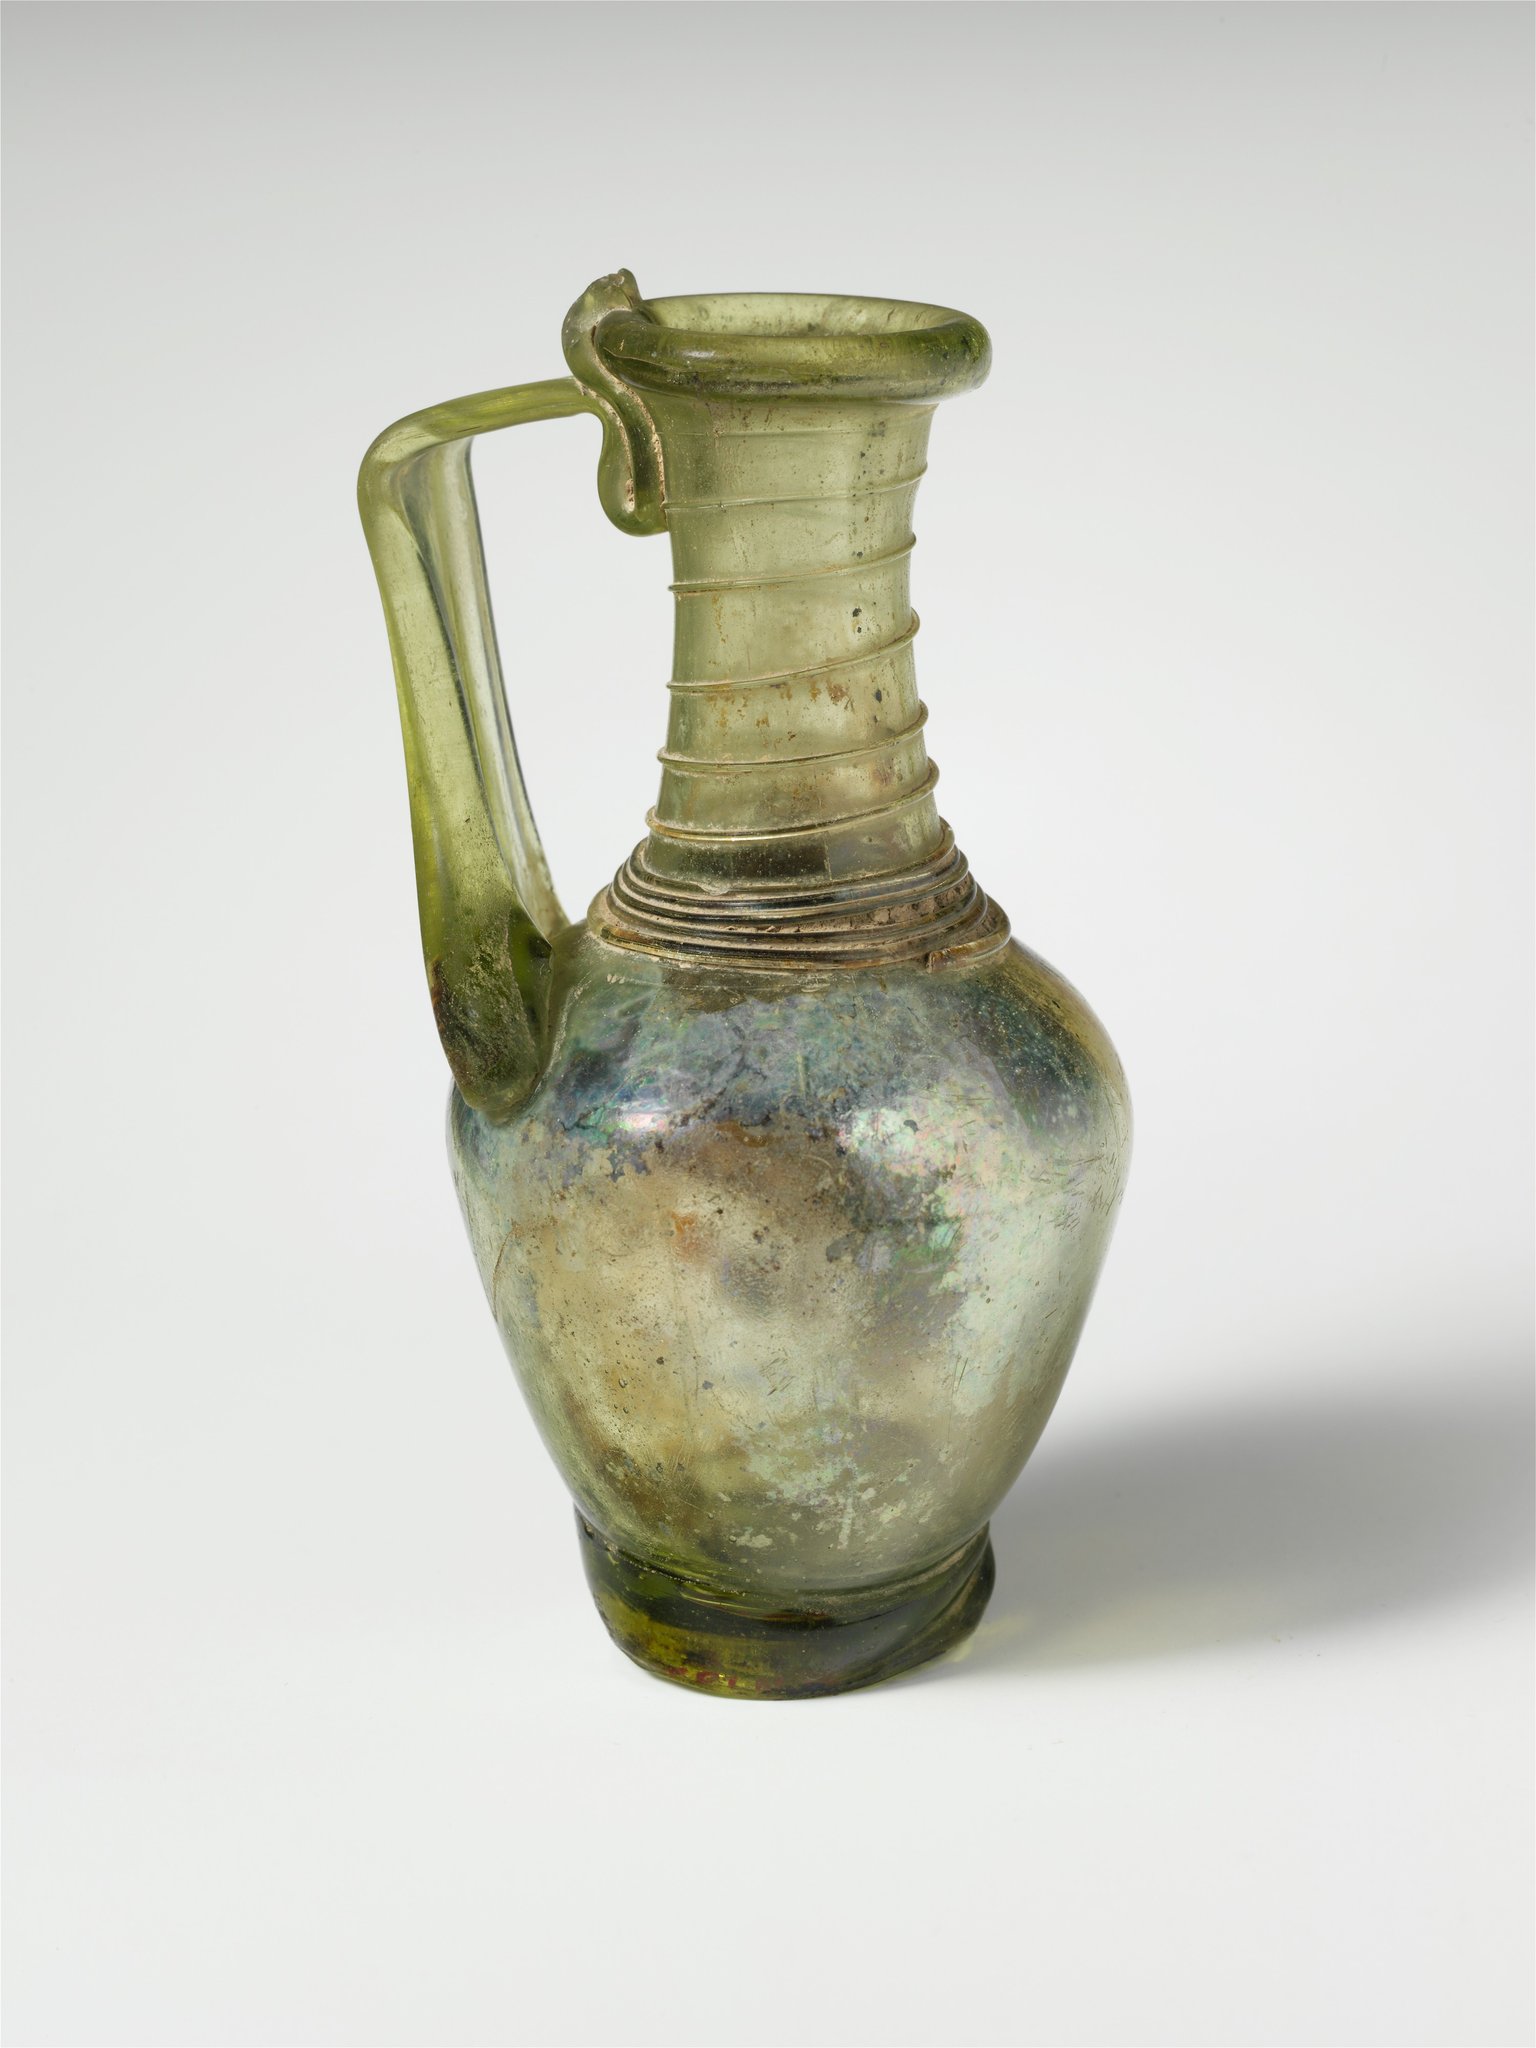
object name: jug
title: Glass jug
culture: roman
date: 301-400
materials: glass